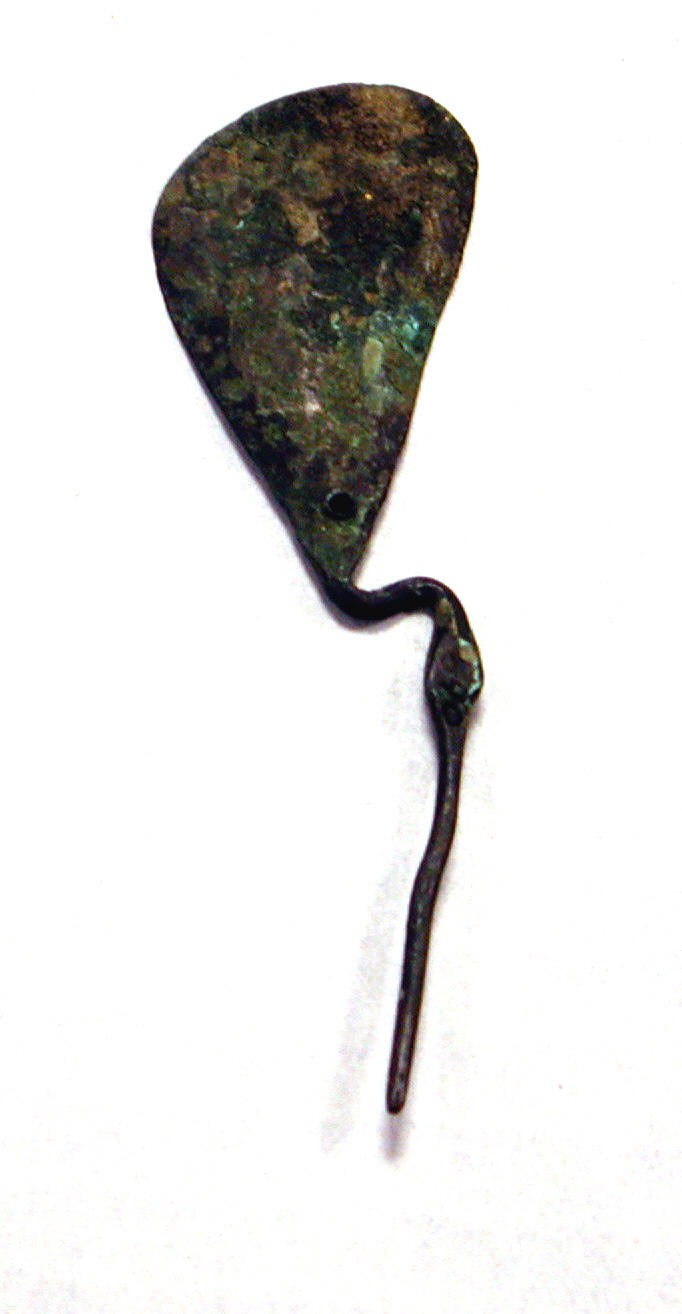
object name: ornament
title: Hammered Copper Spatula (?)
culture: peruvian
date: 701-1566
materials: copper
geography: peru